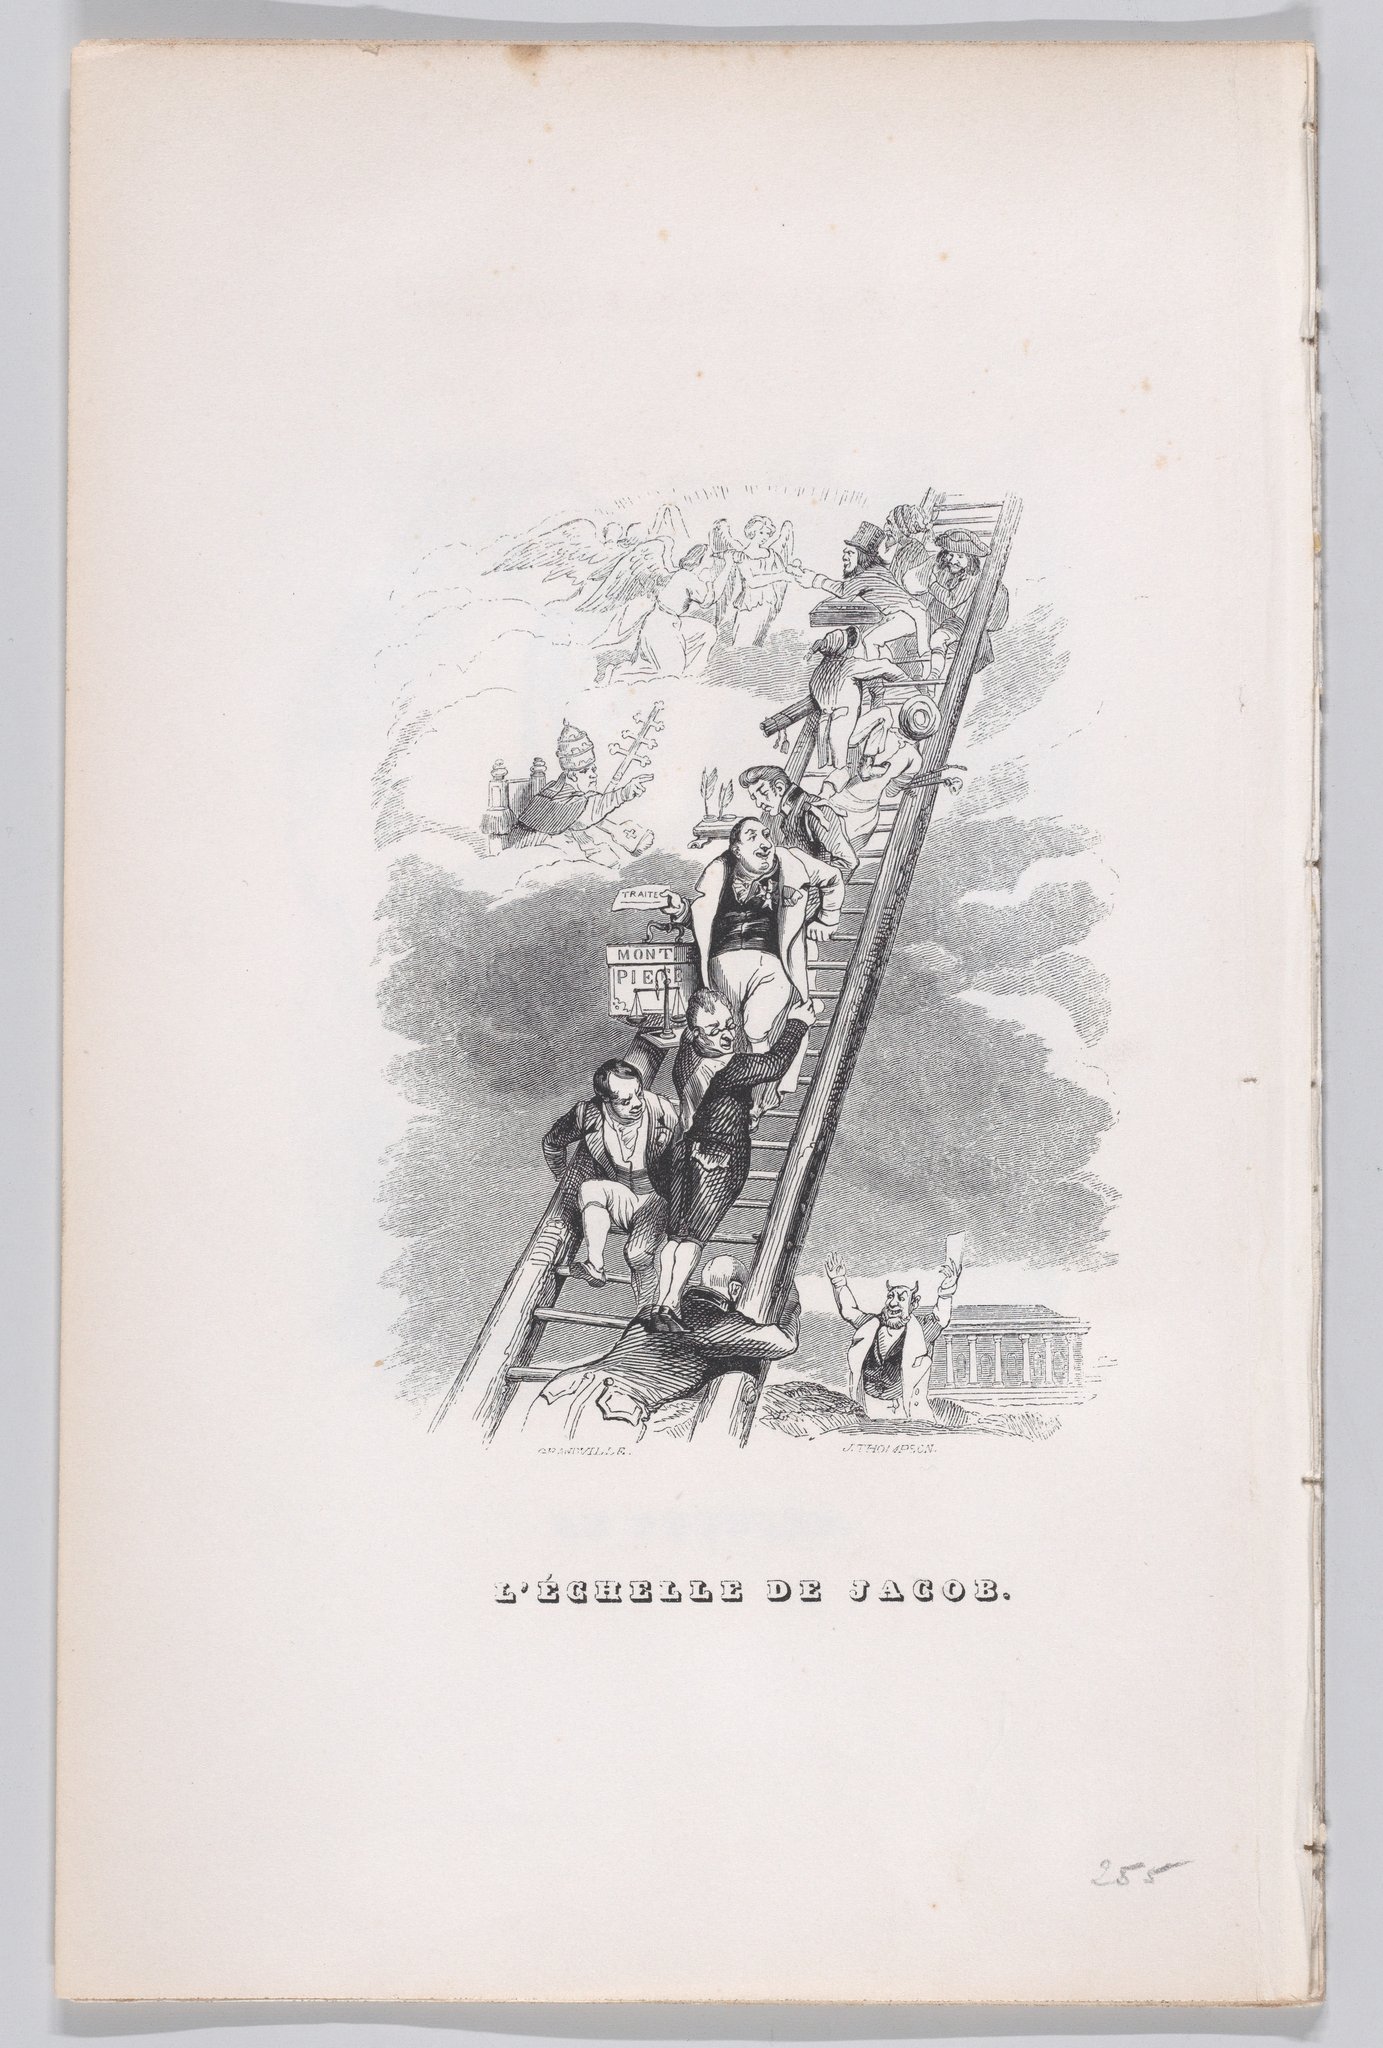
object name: print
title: Jacob's Ladder, from "The Complete Works of Béranger"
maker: j. j. grandville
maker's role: illustrator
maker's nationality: french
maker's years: 1803-1847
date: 1836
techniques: engraving